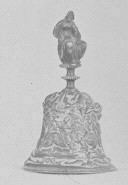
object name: handbell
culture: european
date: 1867-1900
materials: bronze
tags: women